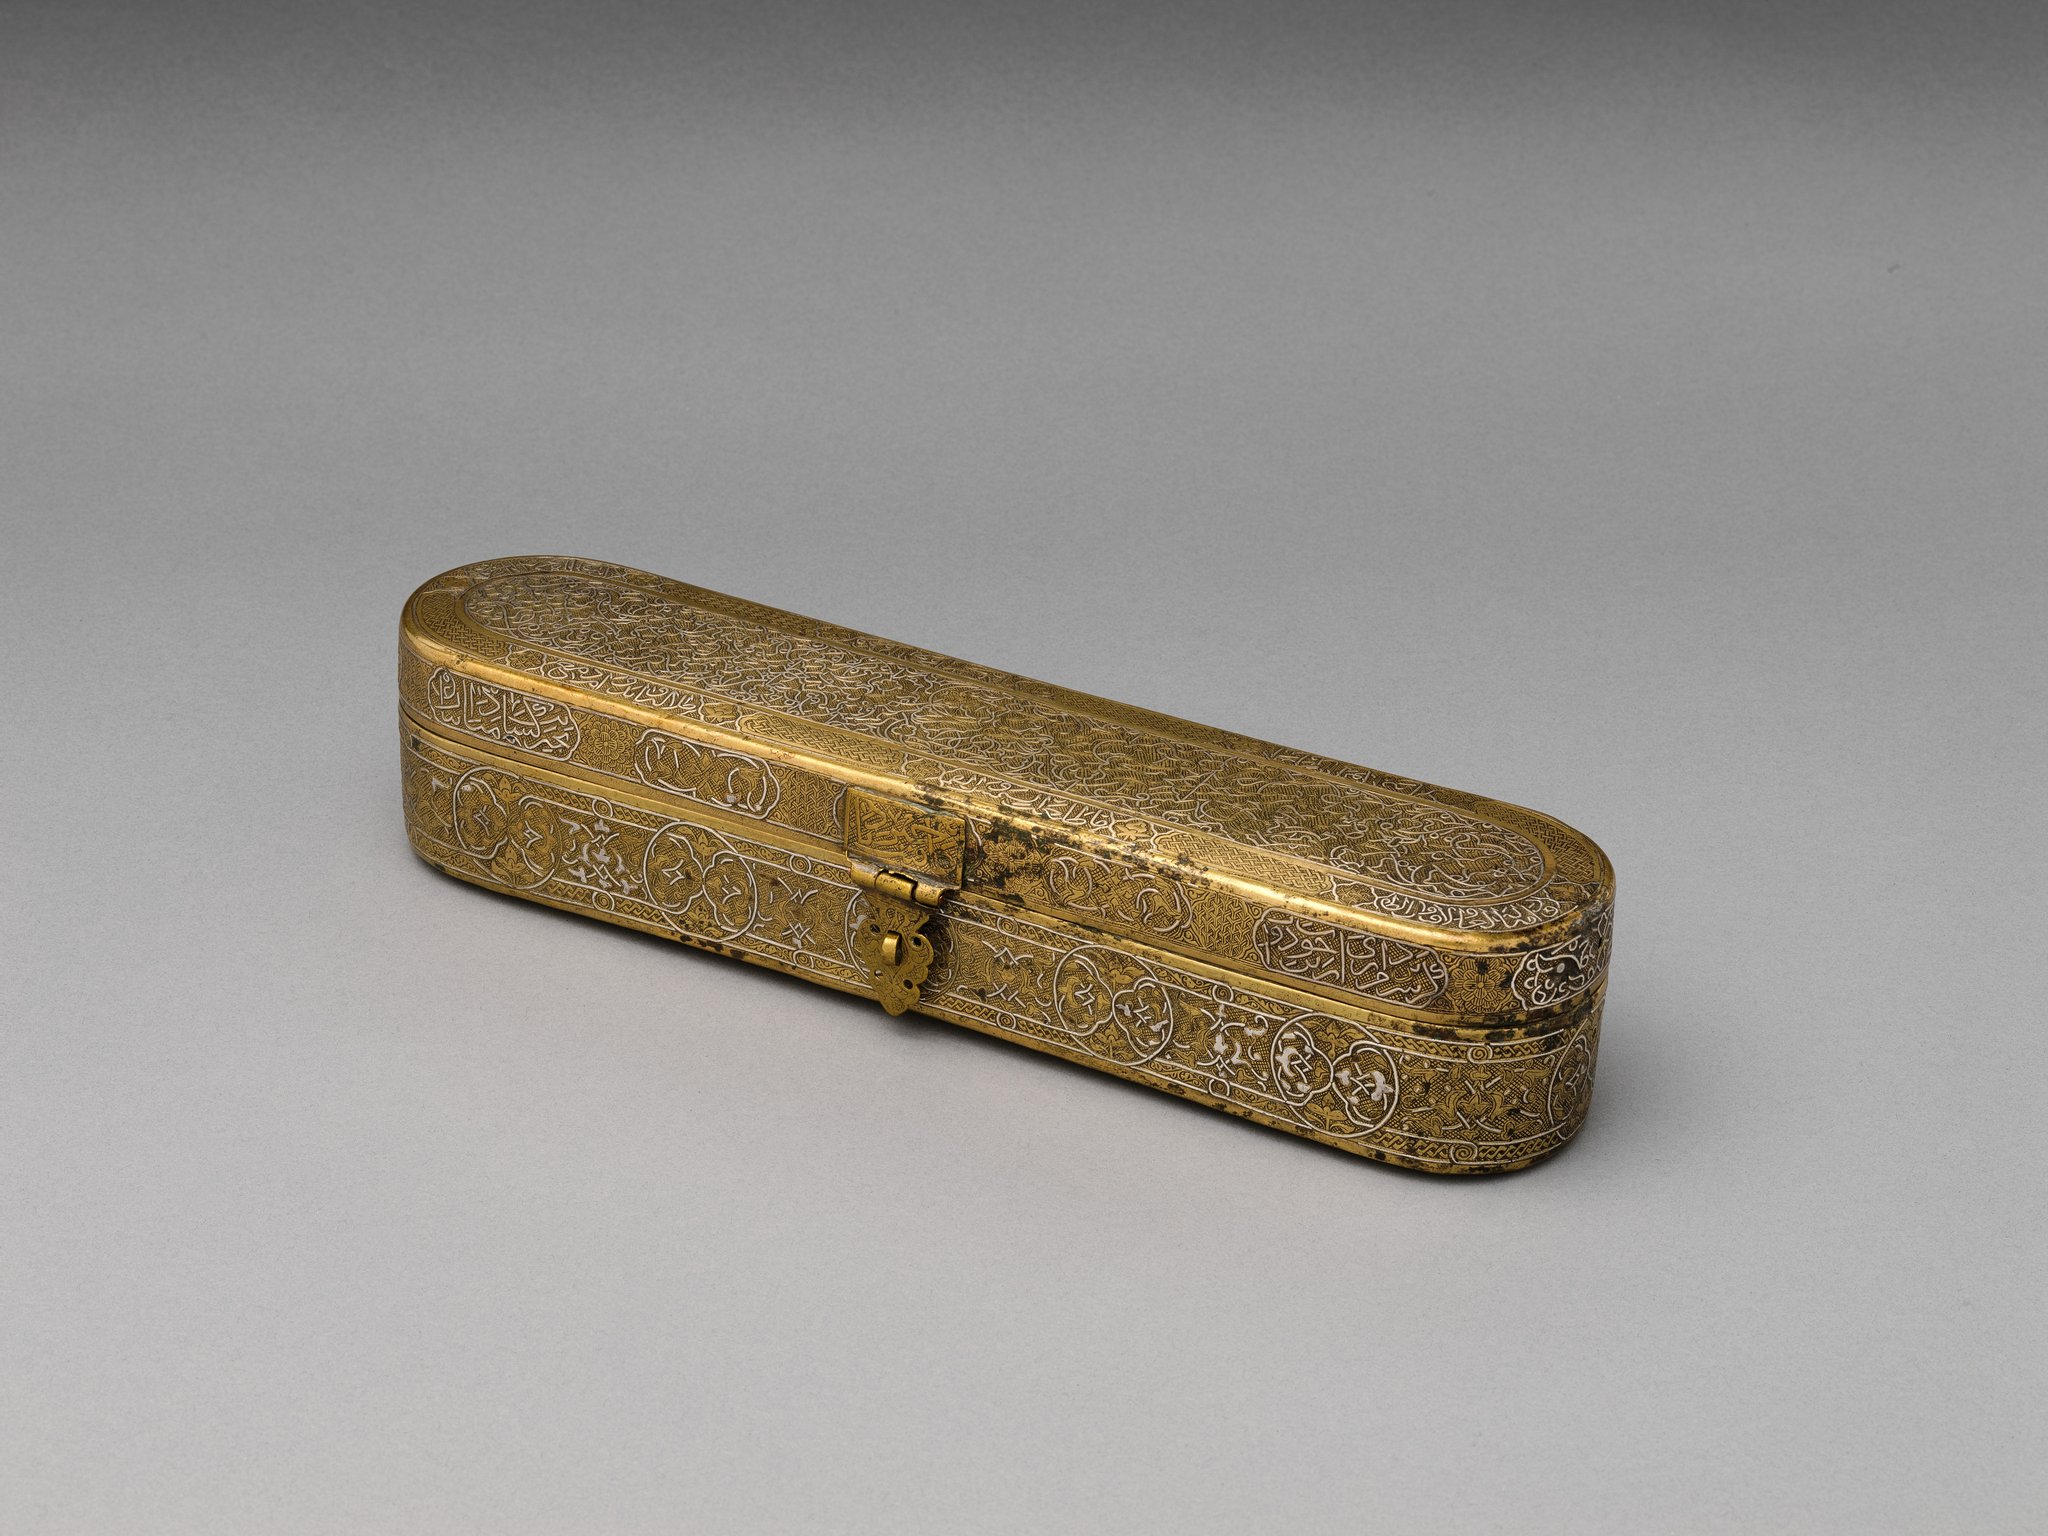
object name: pen box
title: Inscribed Pen Box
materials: brass, gold, silver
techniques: engraving, inlay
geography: afghanistan